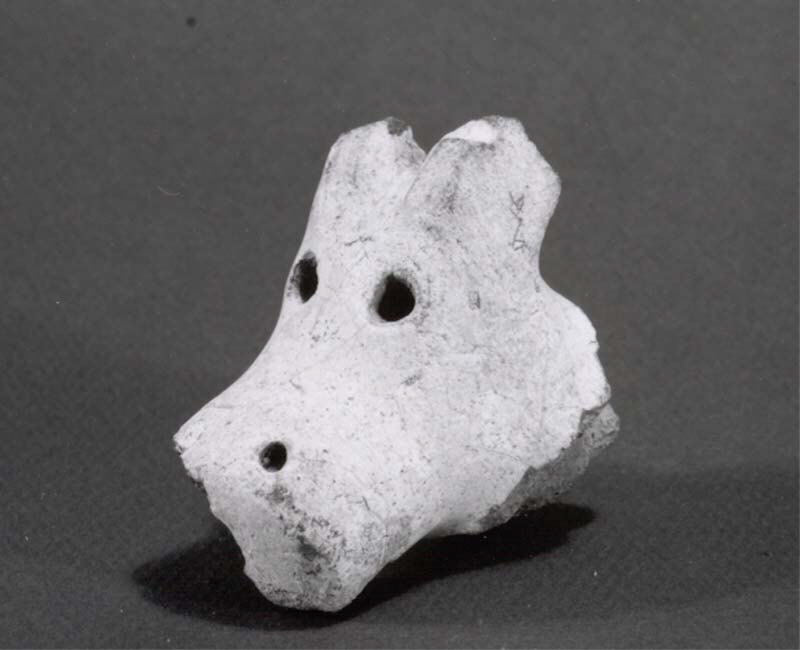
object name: spout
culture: iranian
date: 900-801 BCE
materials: ceramic, glaze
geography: iran